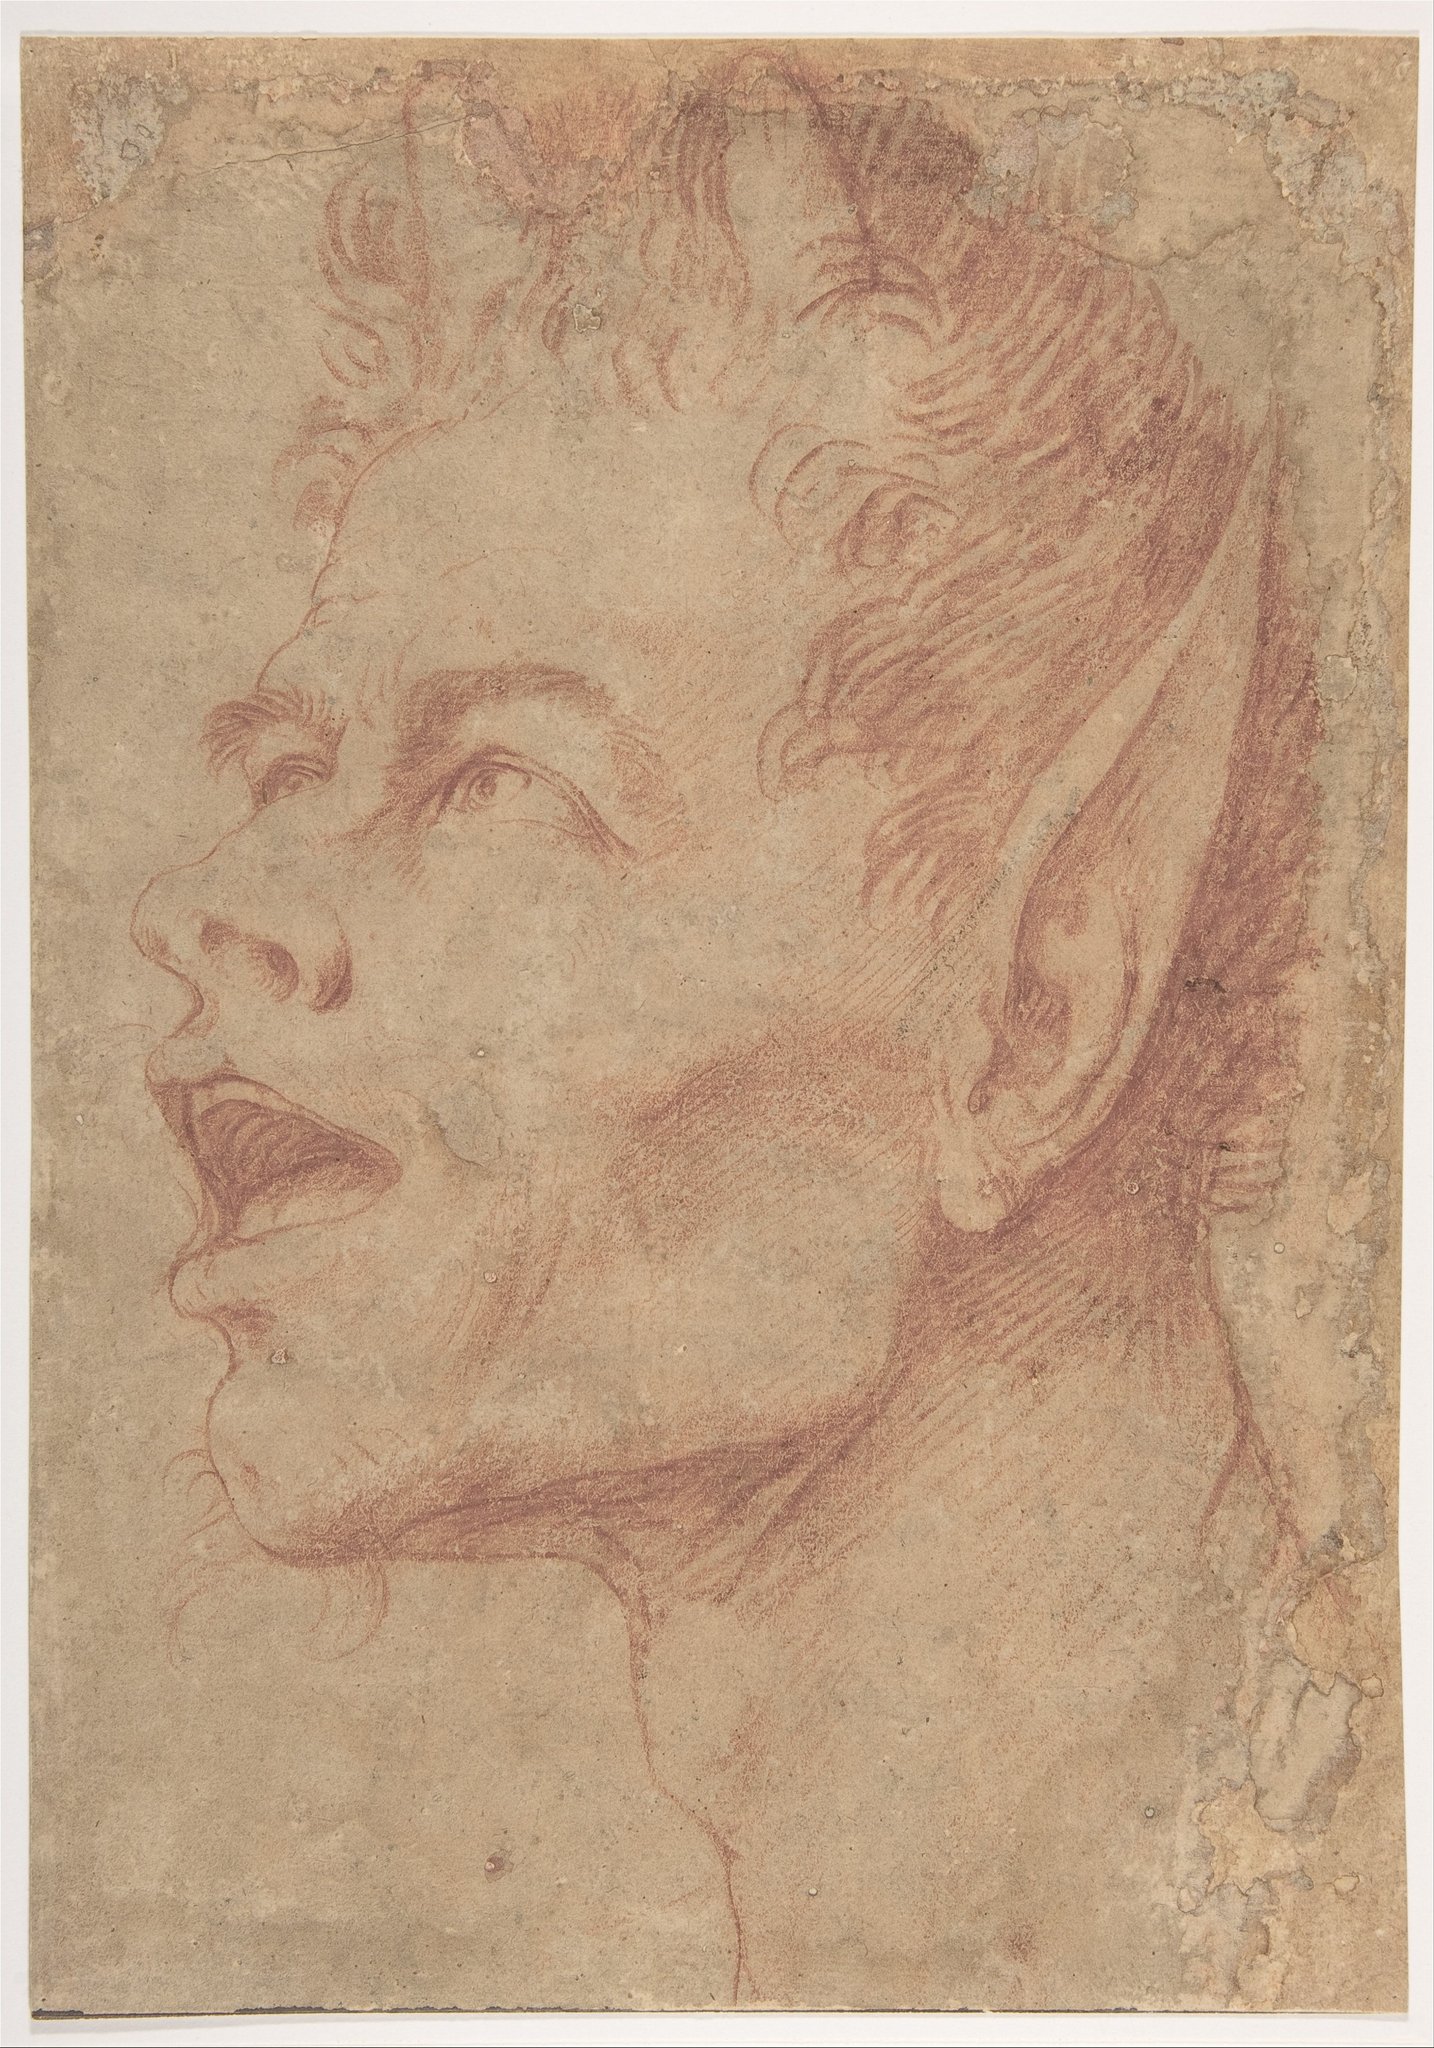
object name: drawing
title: Head of a Satyr Facing Left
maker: jusepe de ribera (called lo spagnoletto)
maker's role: artist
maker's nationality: spanish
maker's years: 1591-1652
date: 1625-1630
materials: chalk, paper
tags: portraits,satyrs